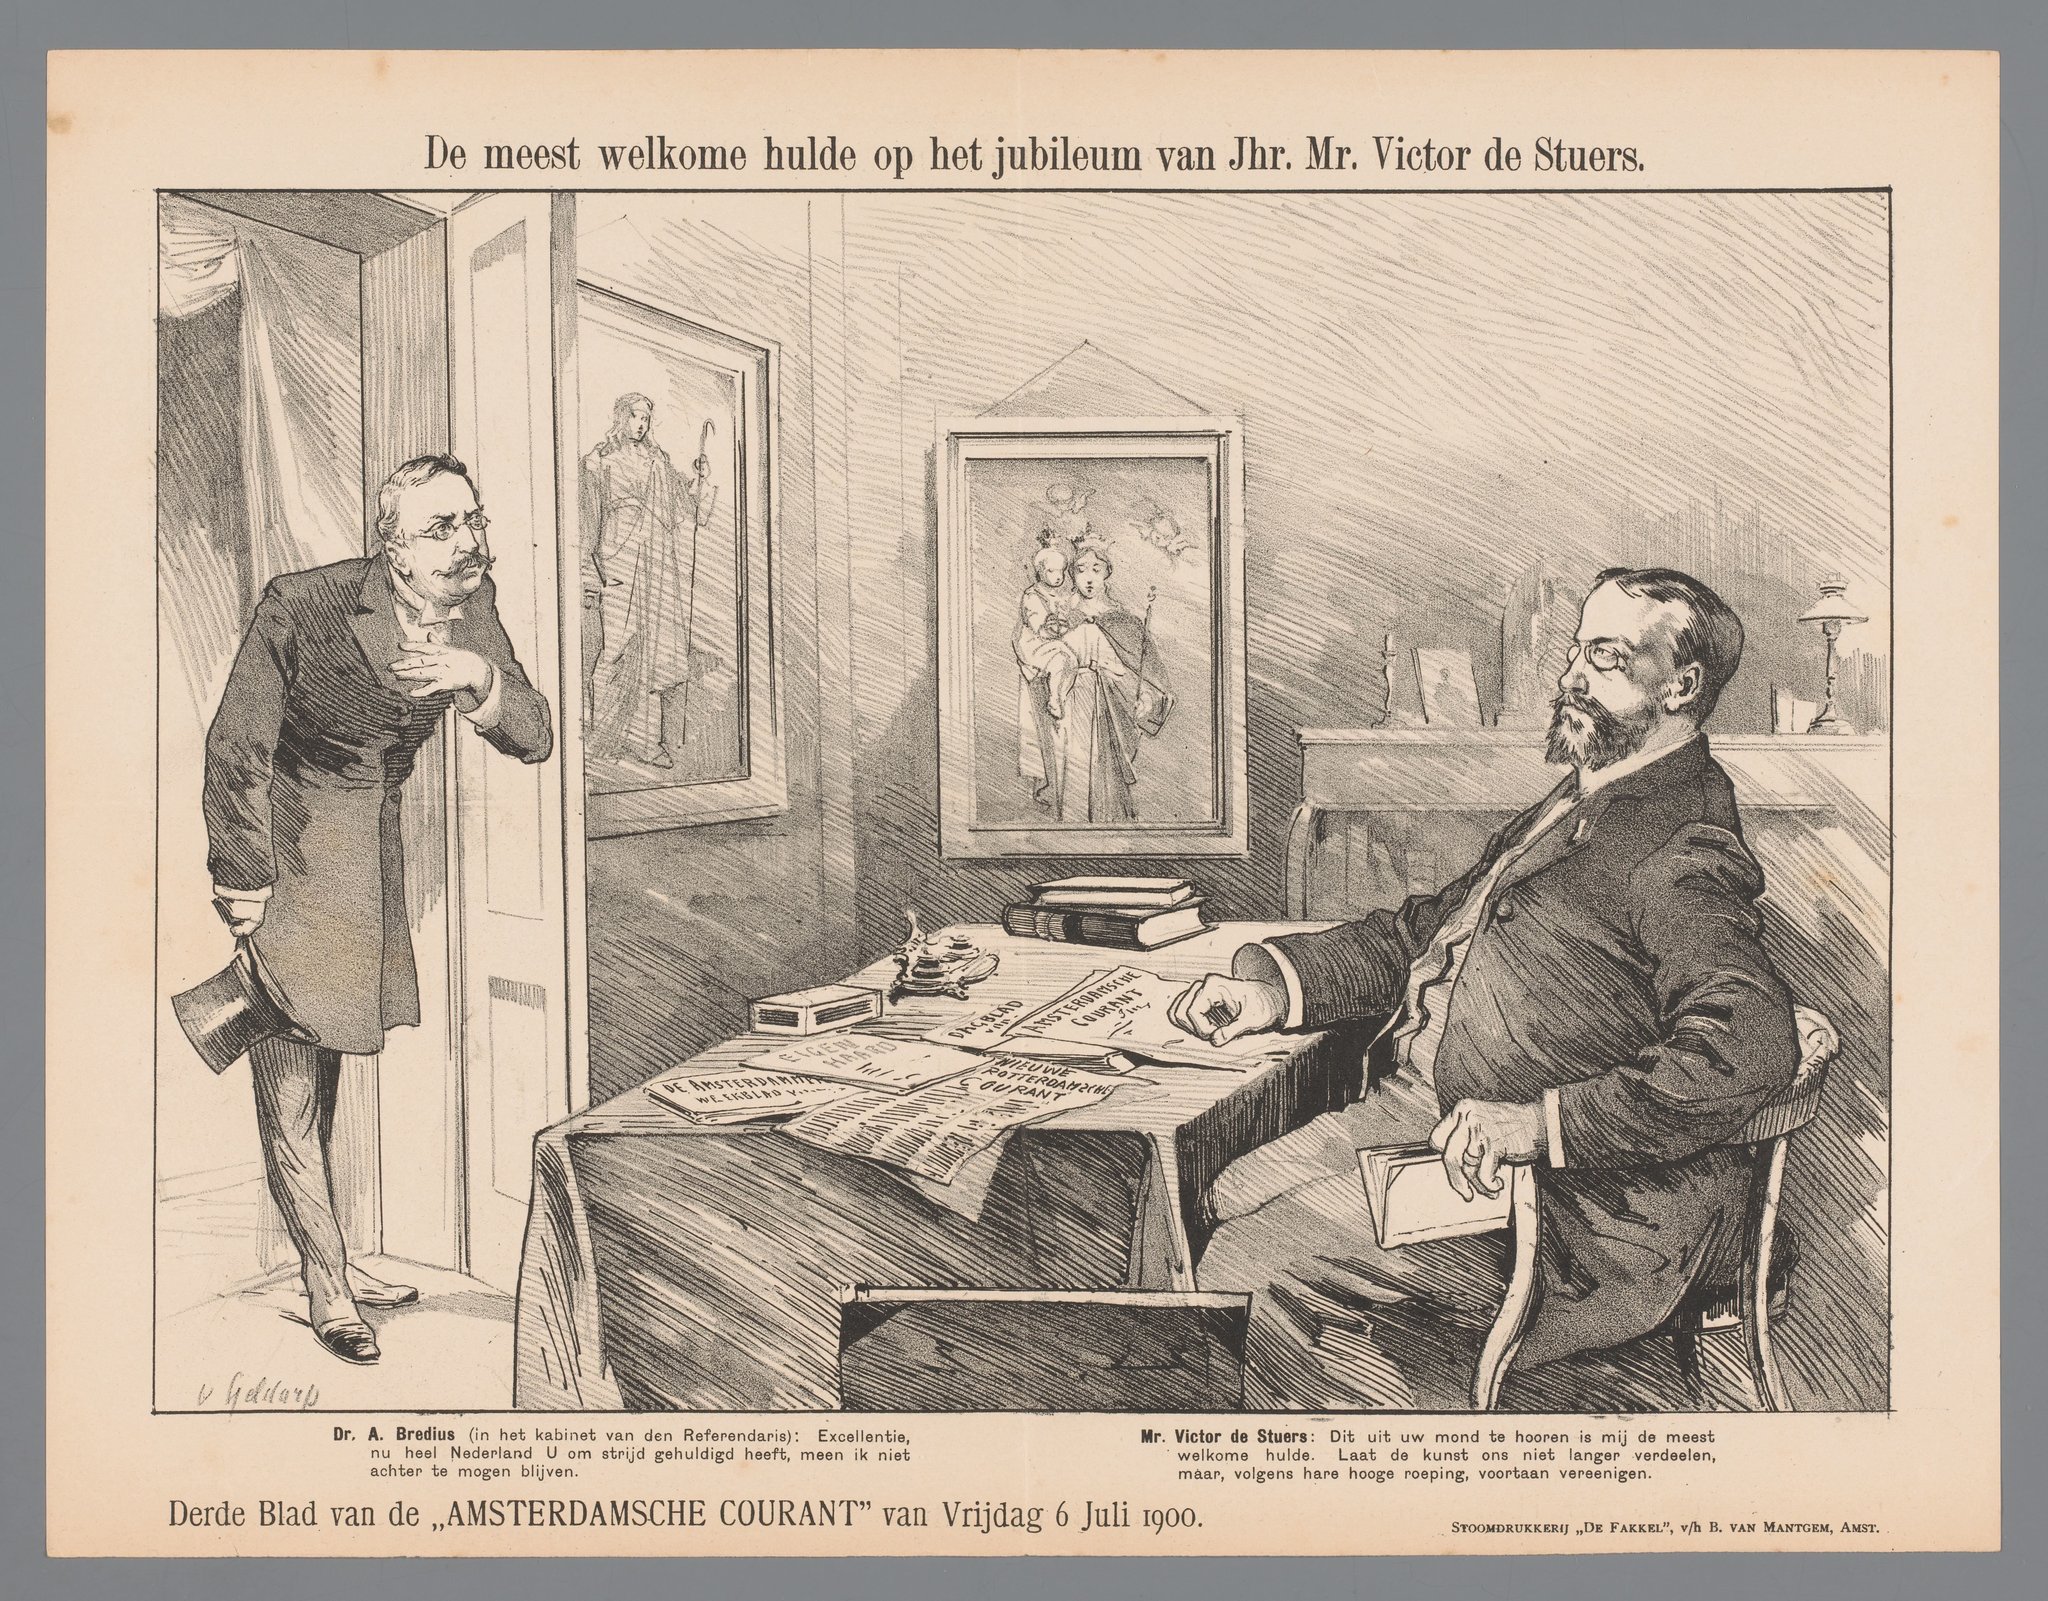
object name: cartoon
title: De meest welkome hulde op het jubileum van Jhr. Mr. Victor de Stuers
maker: petrus van geldorp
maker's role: draughtsman, print maker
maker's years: 1872-1939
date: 1900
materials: paper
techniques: lithograph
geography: amsterdam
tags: maastricht, the hague, print maker, draughtsman, jonkheer victor eugène louis de stuers, amsterdam, abraham bredius, museum personnel, politician, e.g. party leader, picture, painting, political caricatures and satires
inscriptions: date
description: Prent uit het bijvoegsel van: De Amsterdamsche Courant, 6 juli 1900.